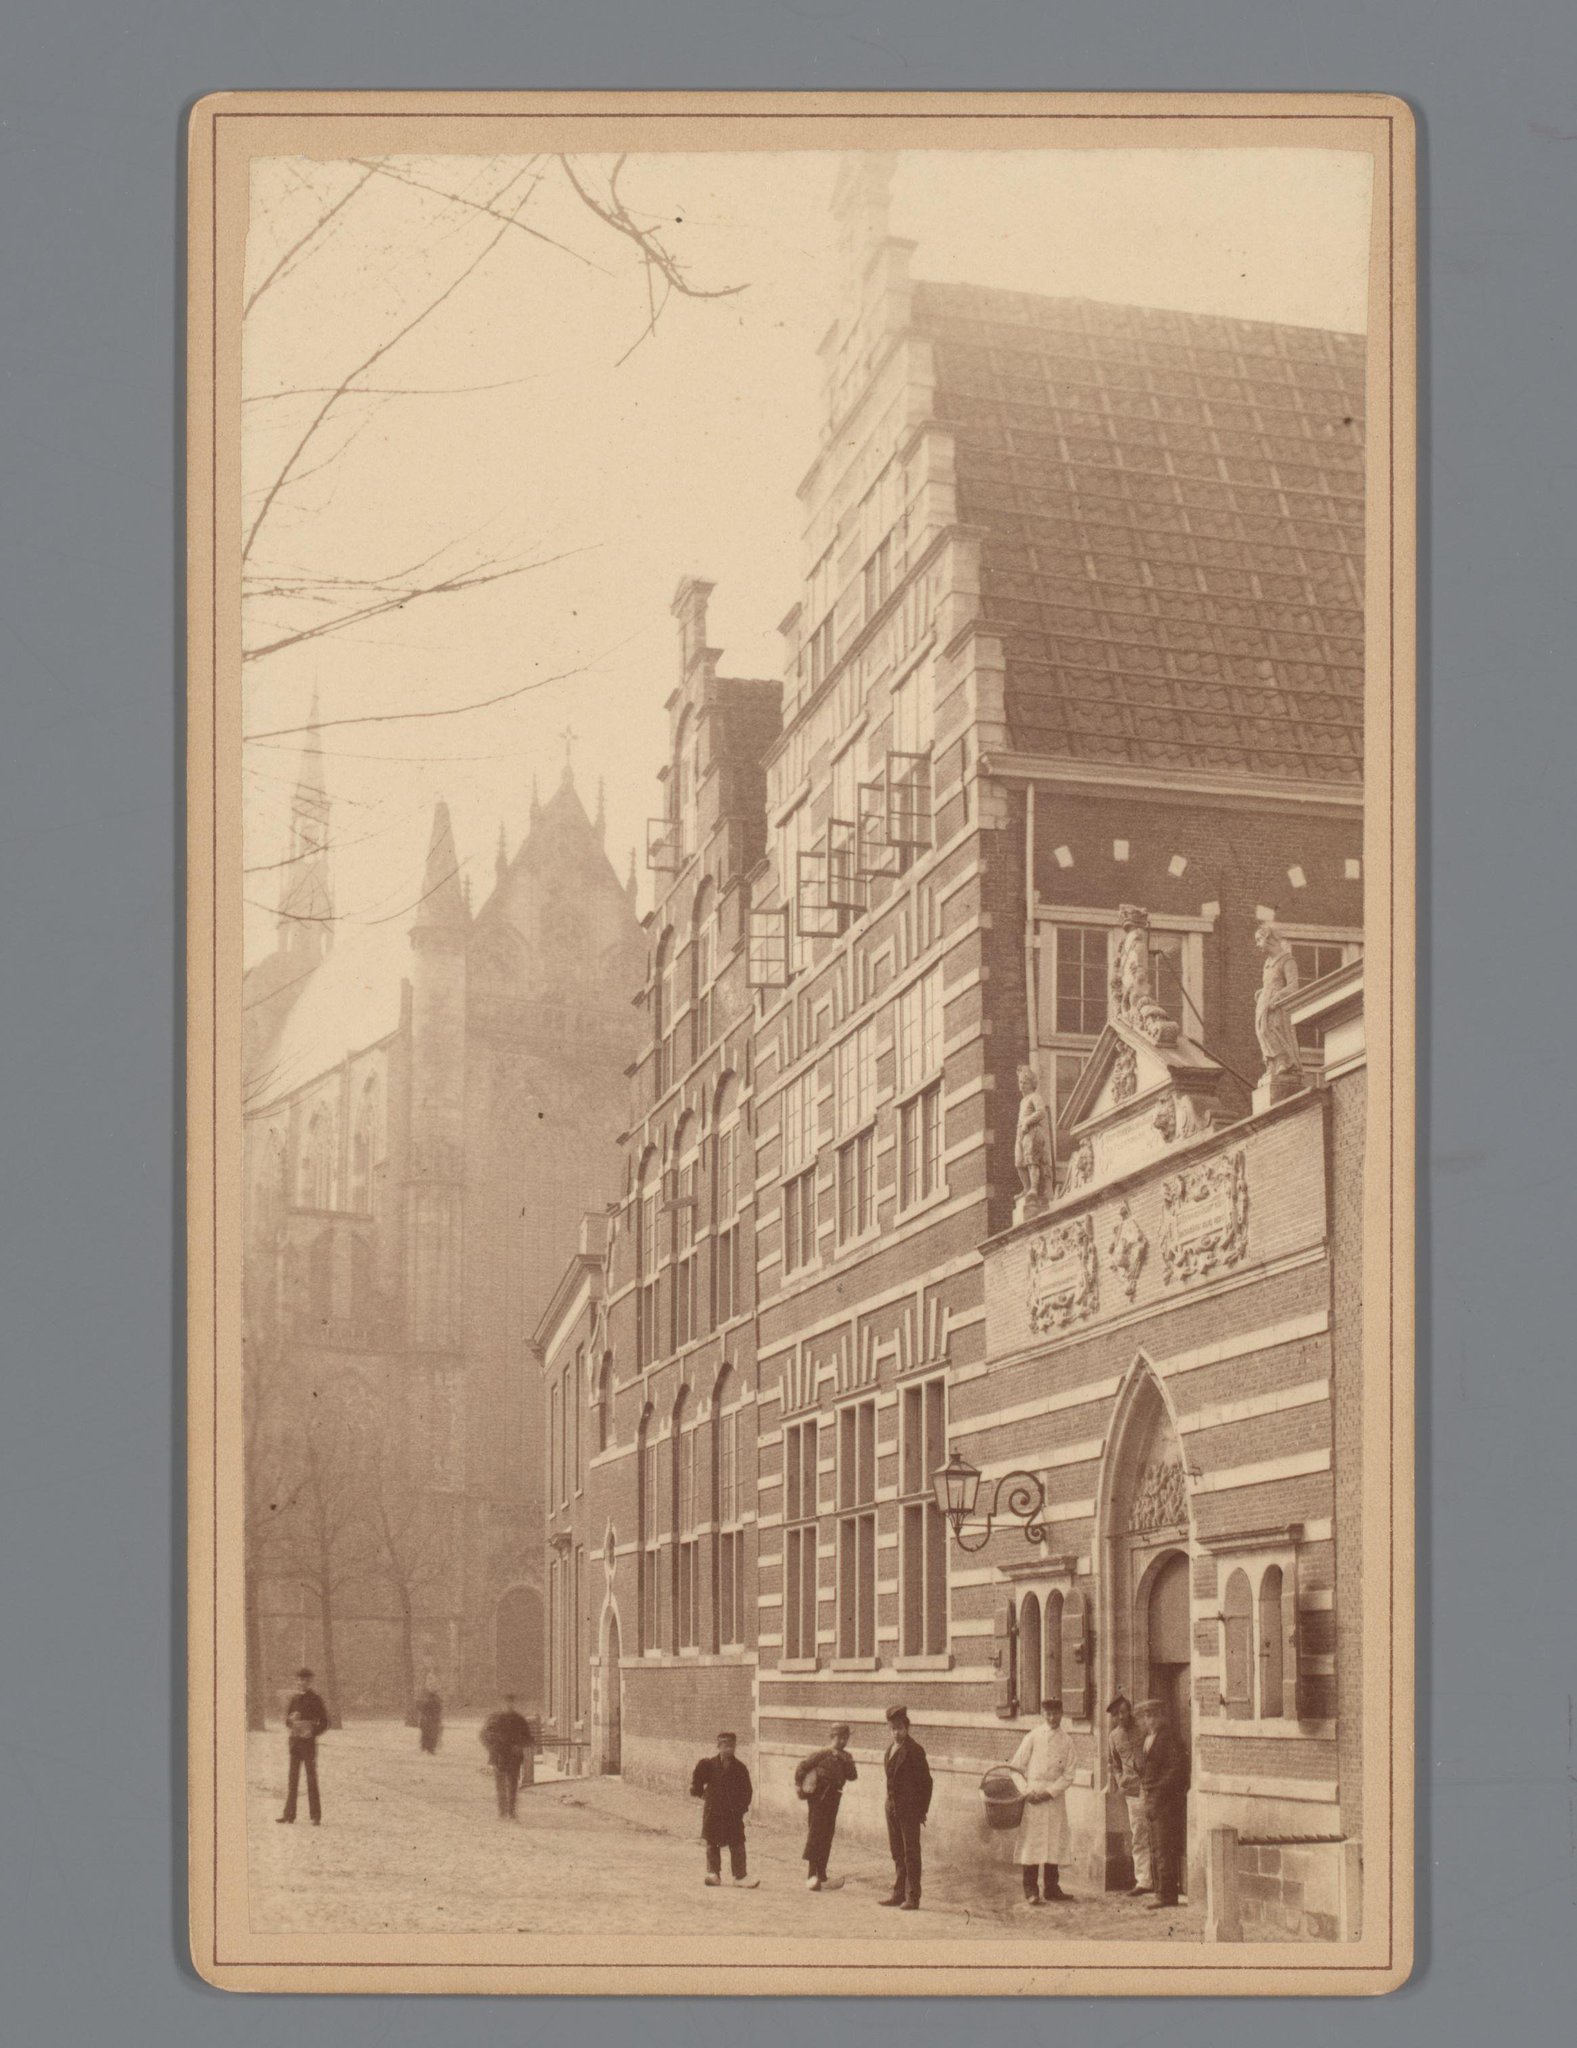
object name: cabinet photograph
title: Gezicht op het weeshuis te Leiden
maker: Anonymous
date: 1870-1900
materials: cardboard, photographic support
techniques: albumen print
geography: leiden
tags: orphanage, leiden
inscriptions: annotation: ‘Weeshuis/ Leiden’